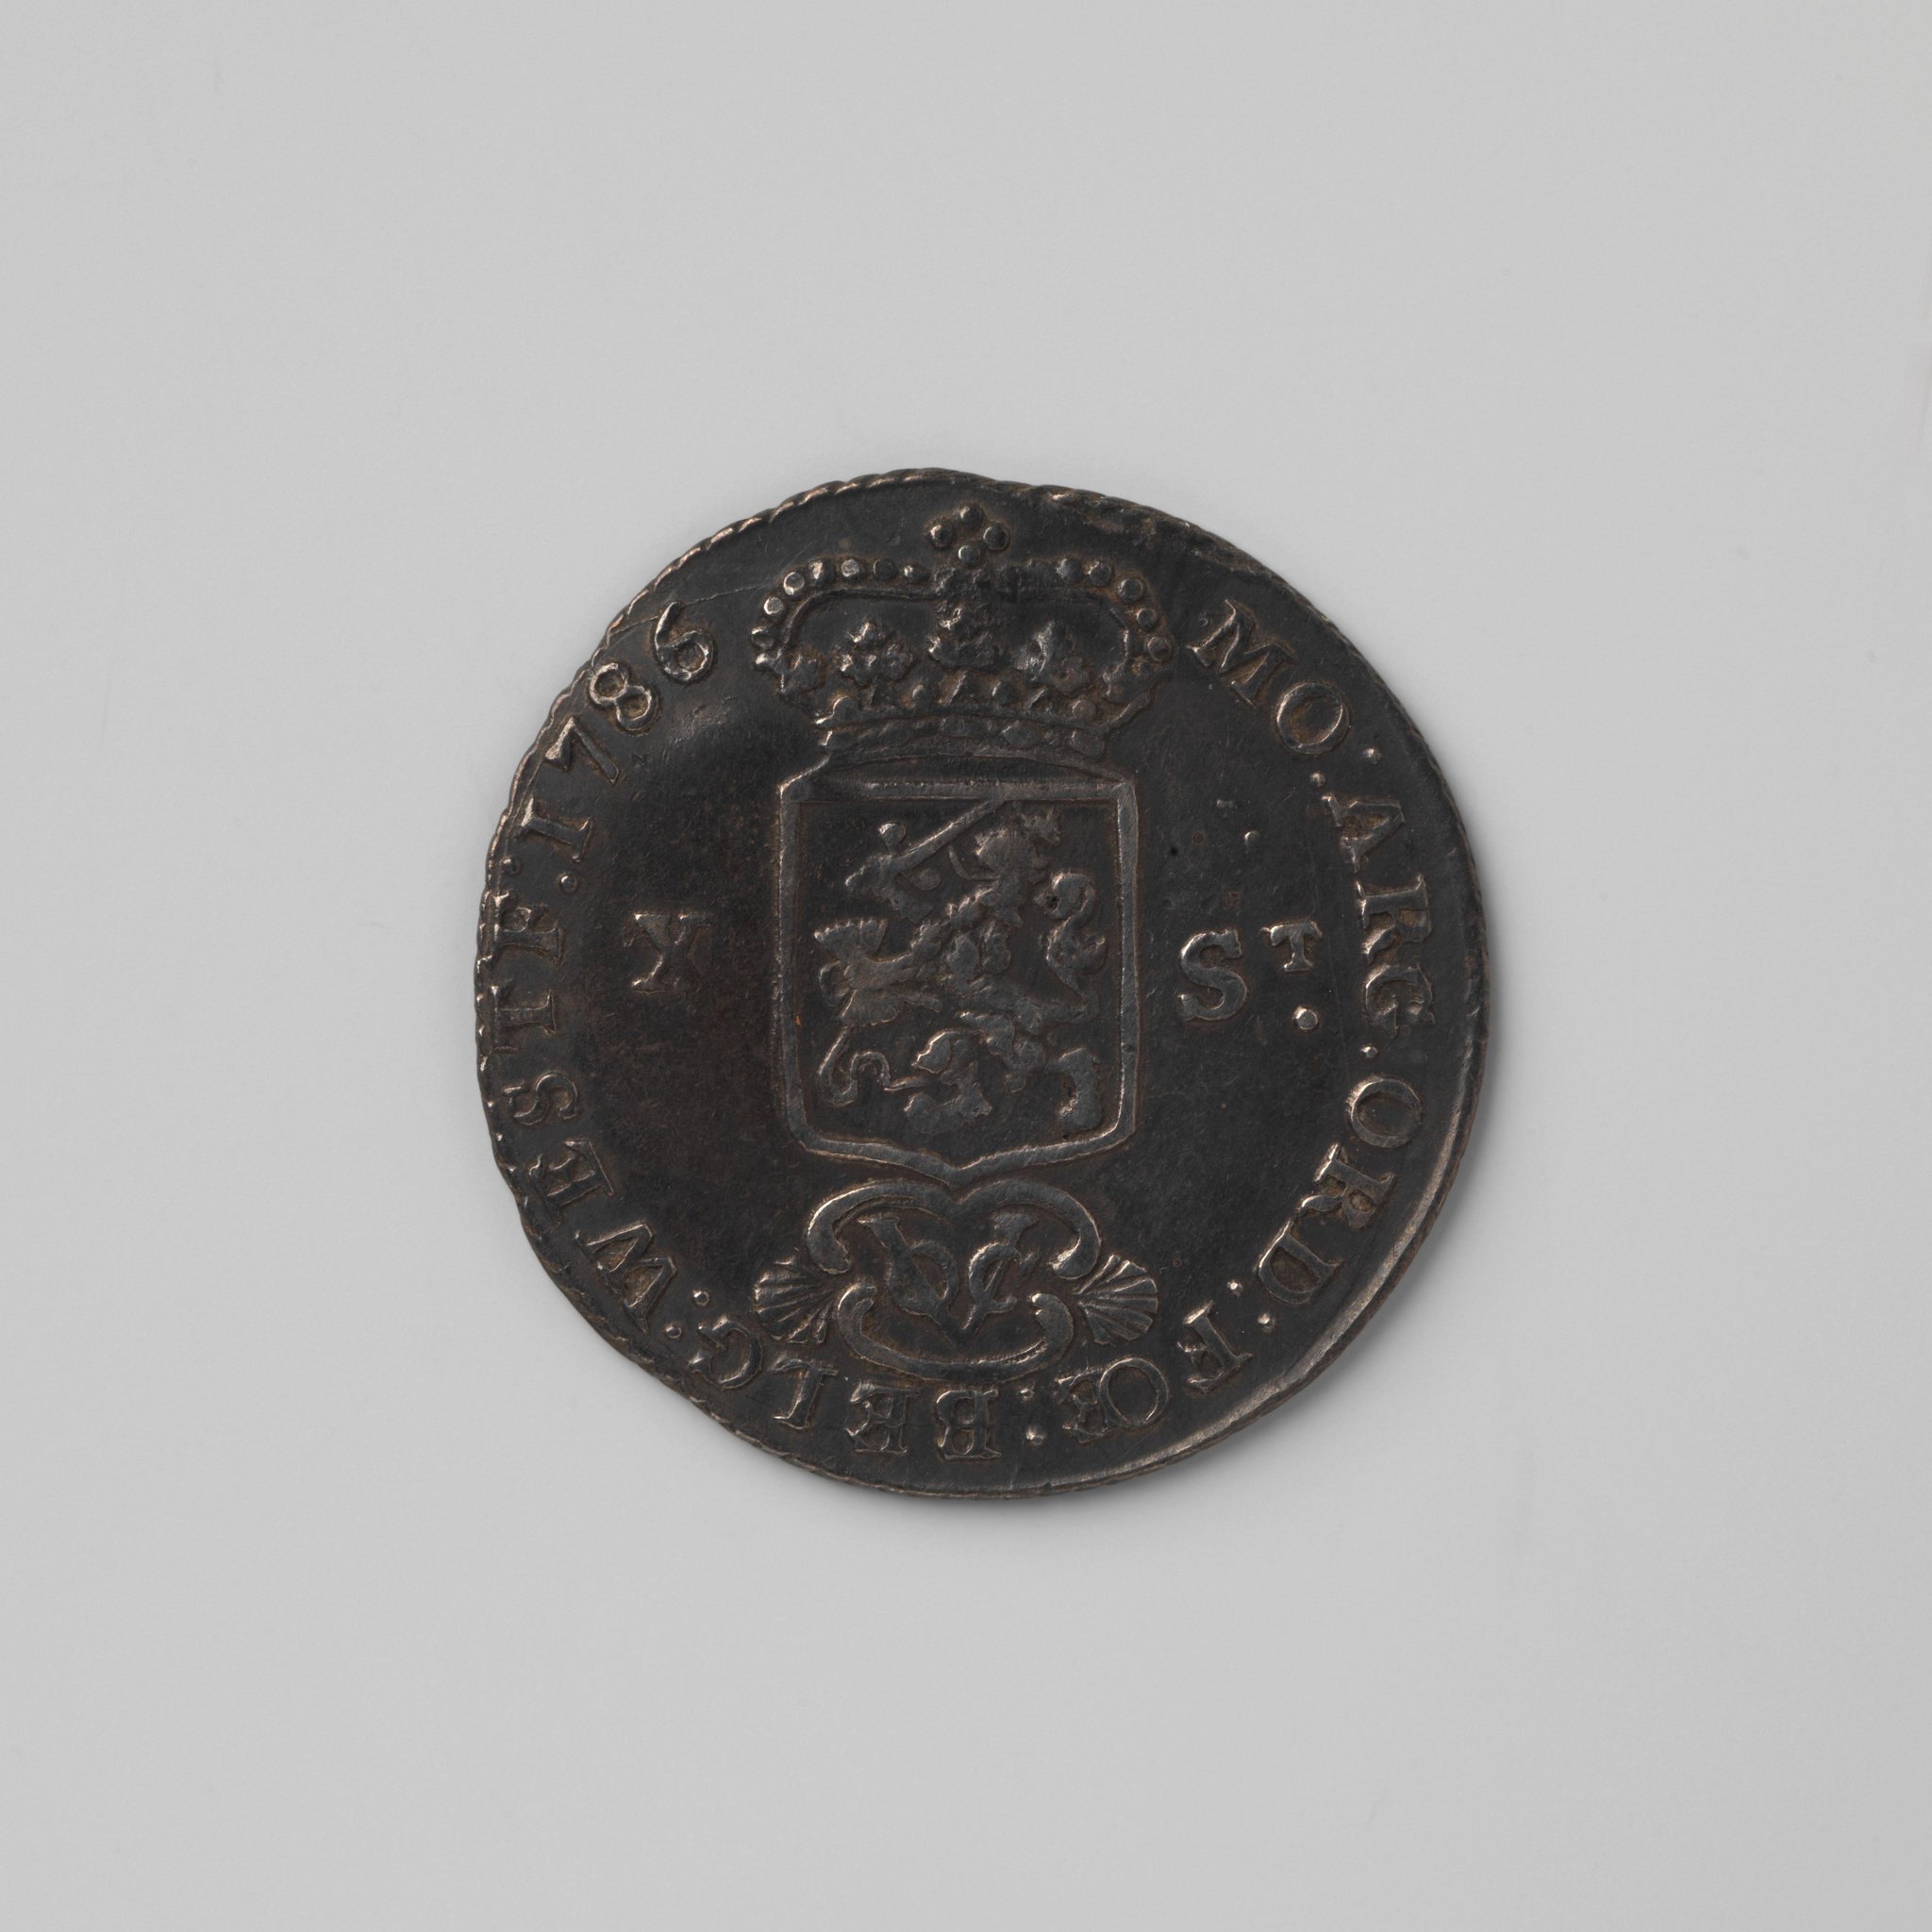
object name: coin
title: ½ gulden van de VOC uit Westfriesland,1786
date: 1786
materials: silver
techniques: striking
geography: hoorn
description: Zilveren munt. Voorzijde: tussen waarde-aanduiding X St. gekroond generaliteitswapenschild, waaronder cartouche, waarin monogram van de VOC. Jaartal aan het eind van het omschrift. Keerzijde: Nederlandse maagd met speer, waarop vrijheidshoed, leunend op een bijbel op een altaar. Kabelrand.